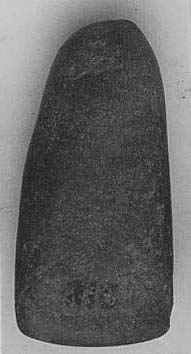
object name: hatchet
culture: french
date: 1902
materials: jade